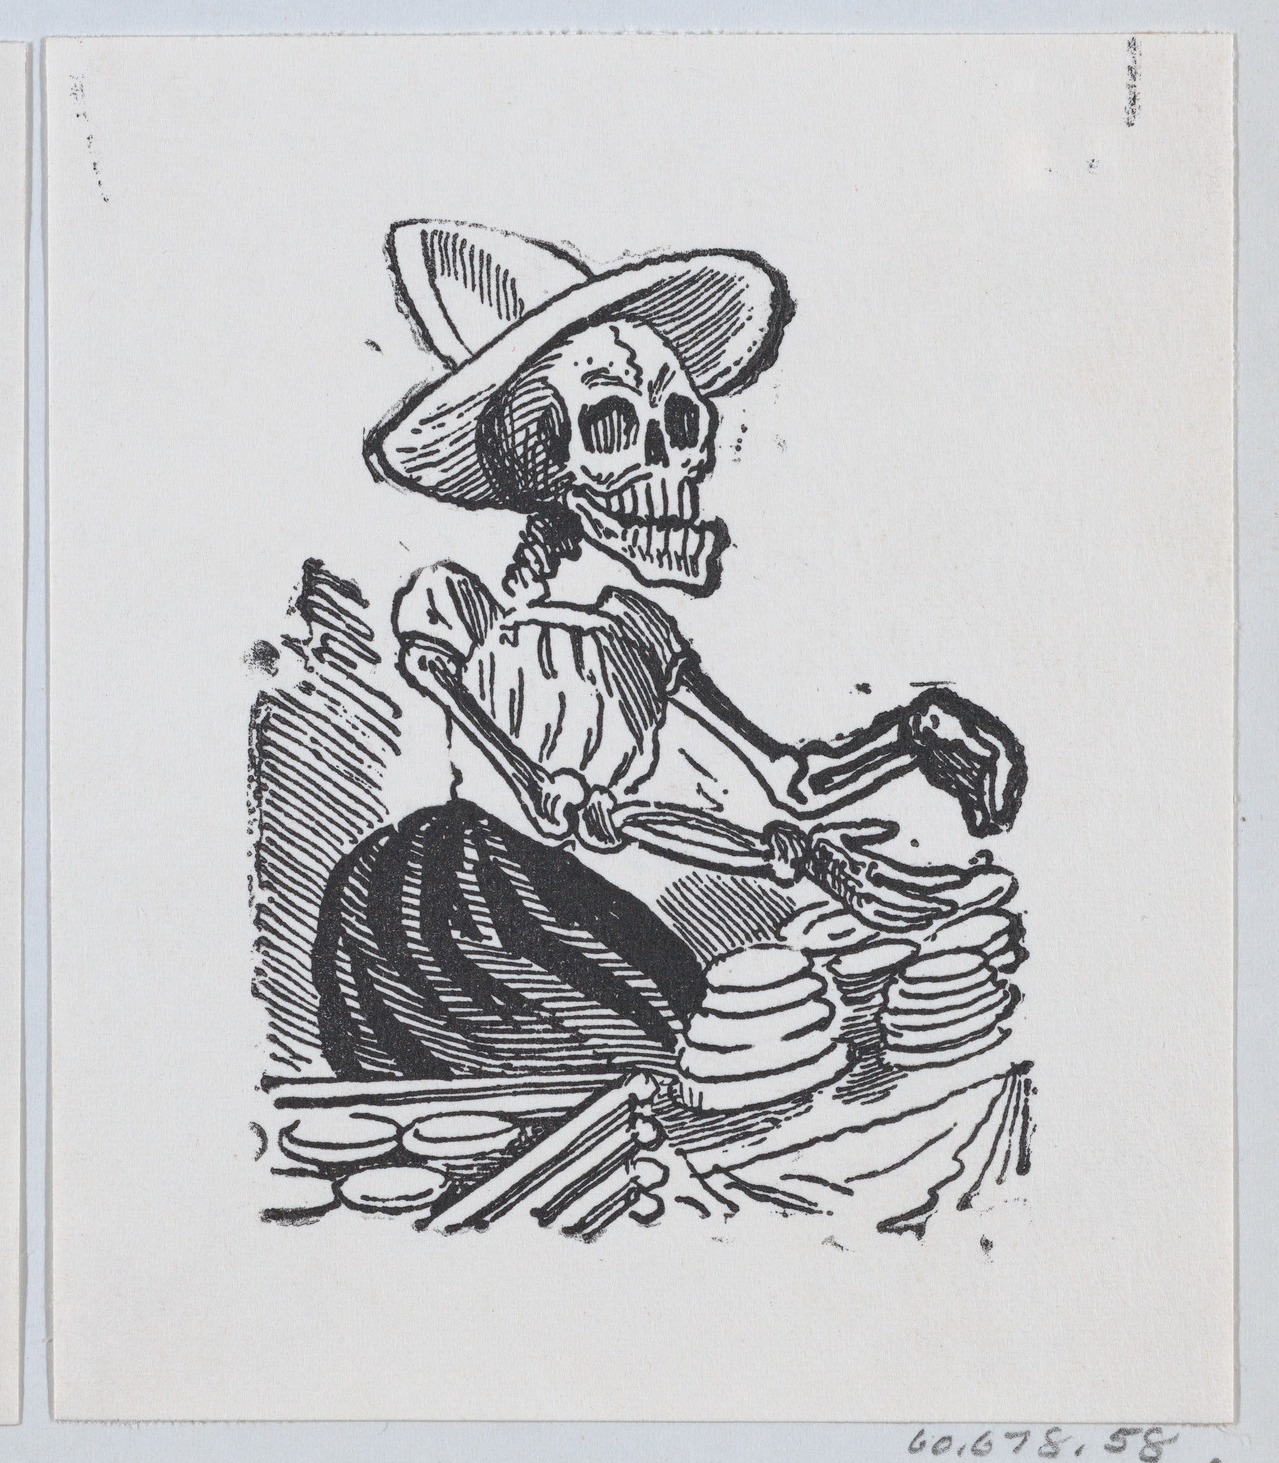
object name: print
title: A skeleton selling cheese from a broadside entitled 'Una Calavera Chusca'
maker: josé guadalupe posada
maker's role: artist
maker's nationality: mexican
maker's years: 1852-1913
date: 1880-1910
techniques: lithography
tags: cheese,skeletons